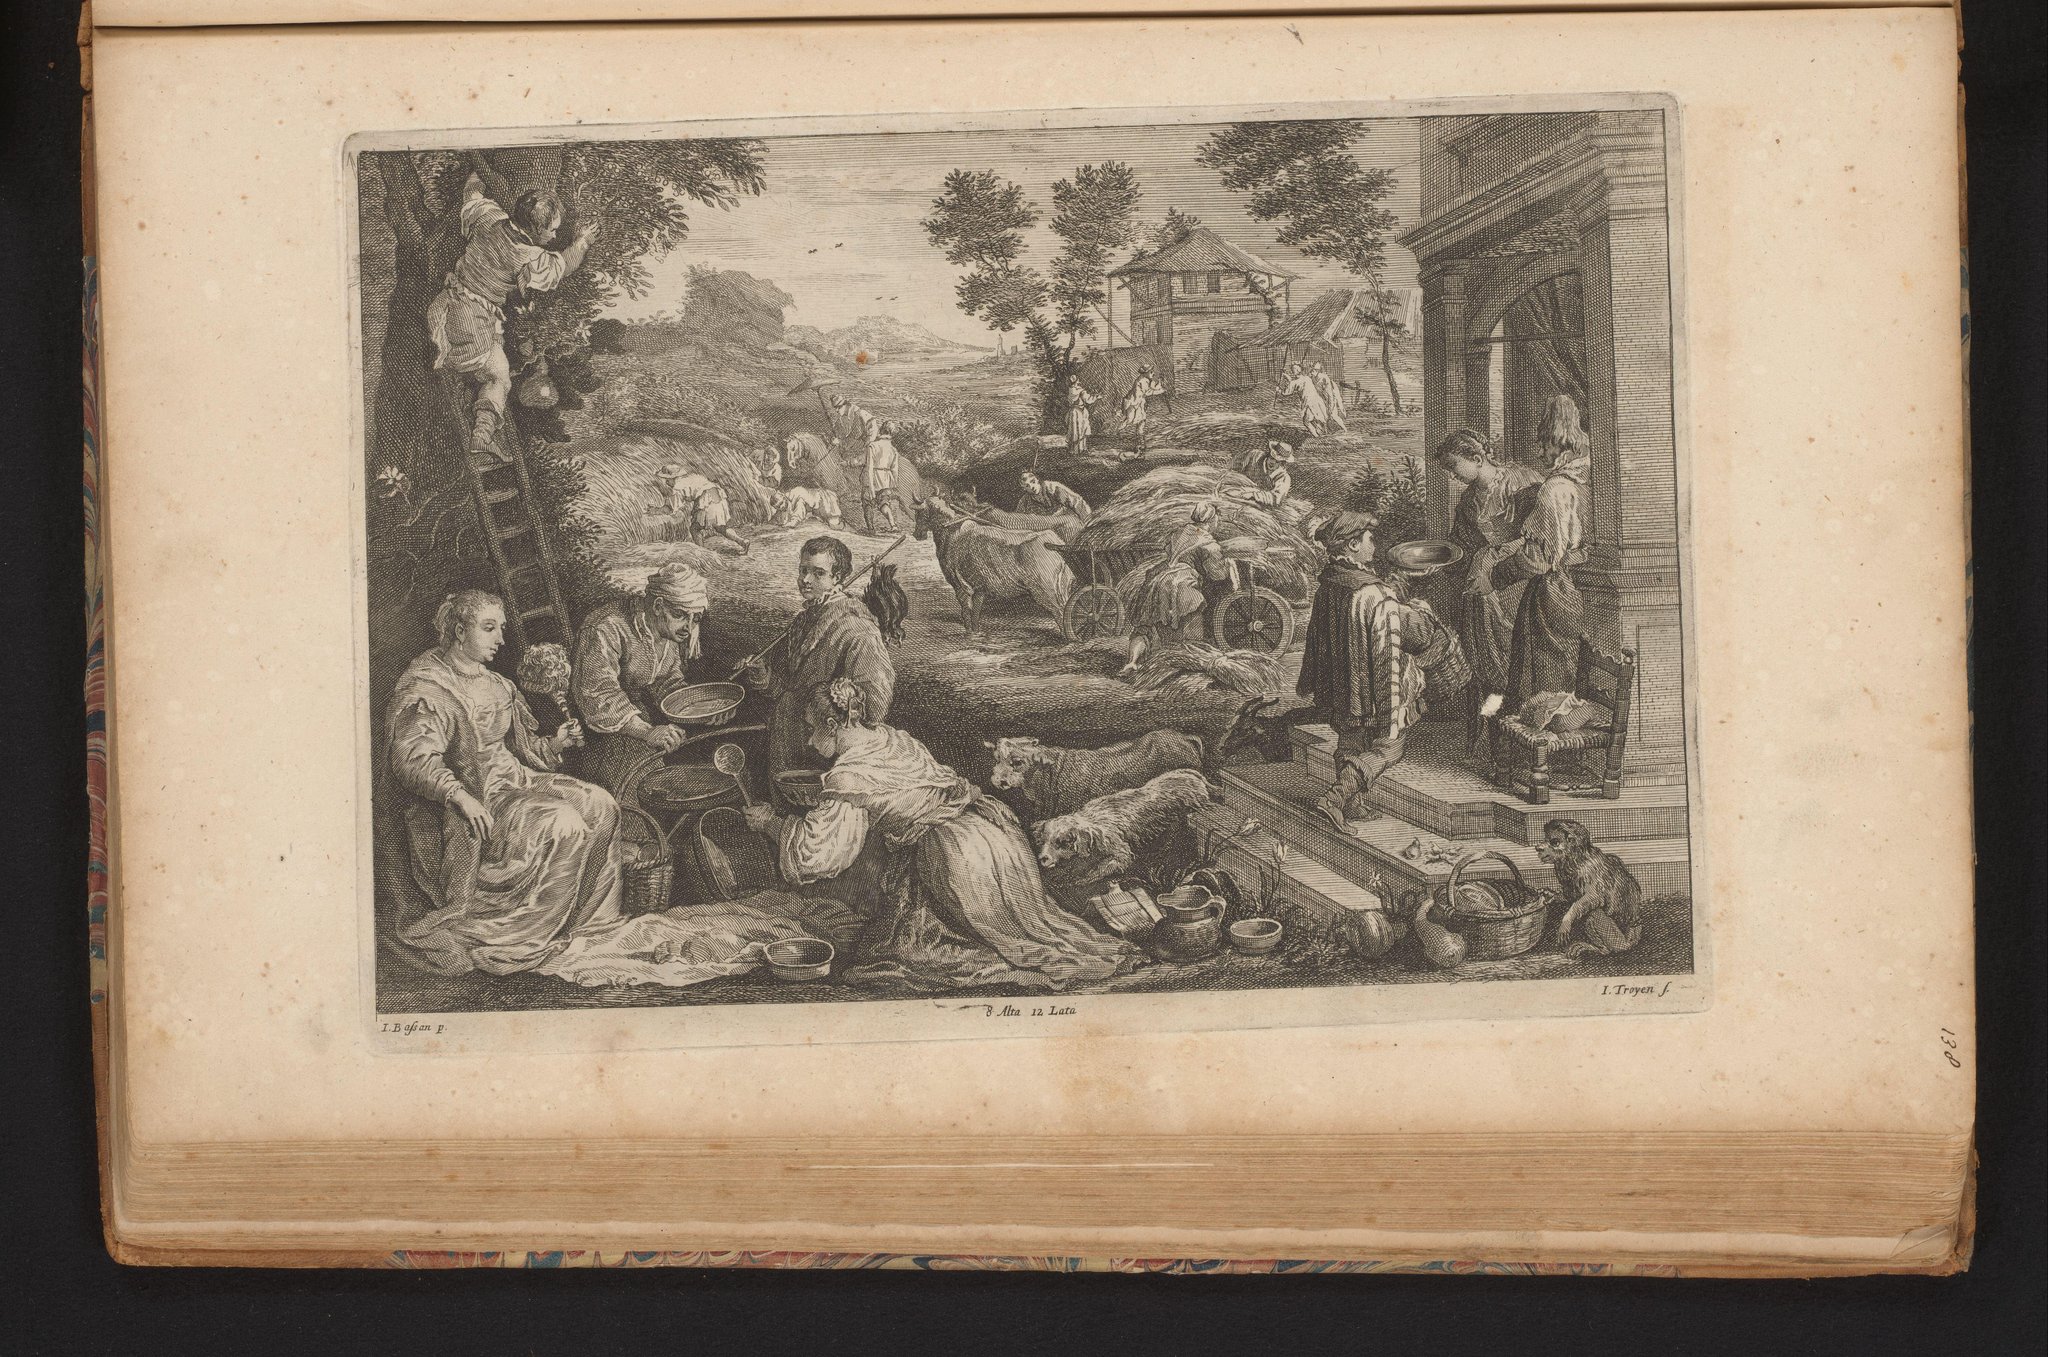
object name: album leaf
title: Zomer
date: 1660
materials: paper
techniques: etching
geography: southern netherlands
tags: summer ~ human activities (the four seasons of the year) (+ with scenes showing human occupations ~ seasons and months), selling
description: De prent is vervaardigd naar het schilderij van Bassano dat zich in de collectie van het Kunsthistorisches Museum te Wenen bevindt (inventarisnummer GG_4289). David Teniers heeft waarschijnlijk van alle schilderijen uit de collectie van Leopold Willem van Oostenrijk een olieverfstudie op doek of paneel vervaardigd (zgn. pasticcio), die als voorbeeld voor de prentmakers diende. Het is niet altijd duidelijk of de pasticci door hem zijn gemaakt of door zijn atelier. Niet alle pasticci zijn overgeleverd.